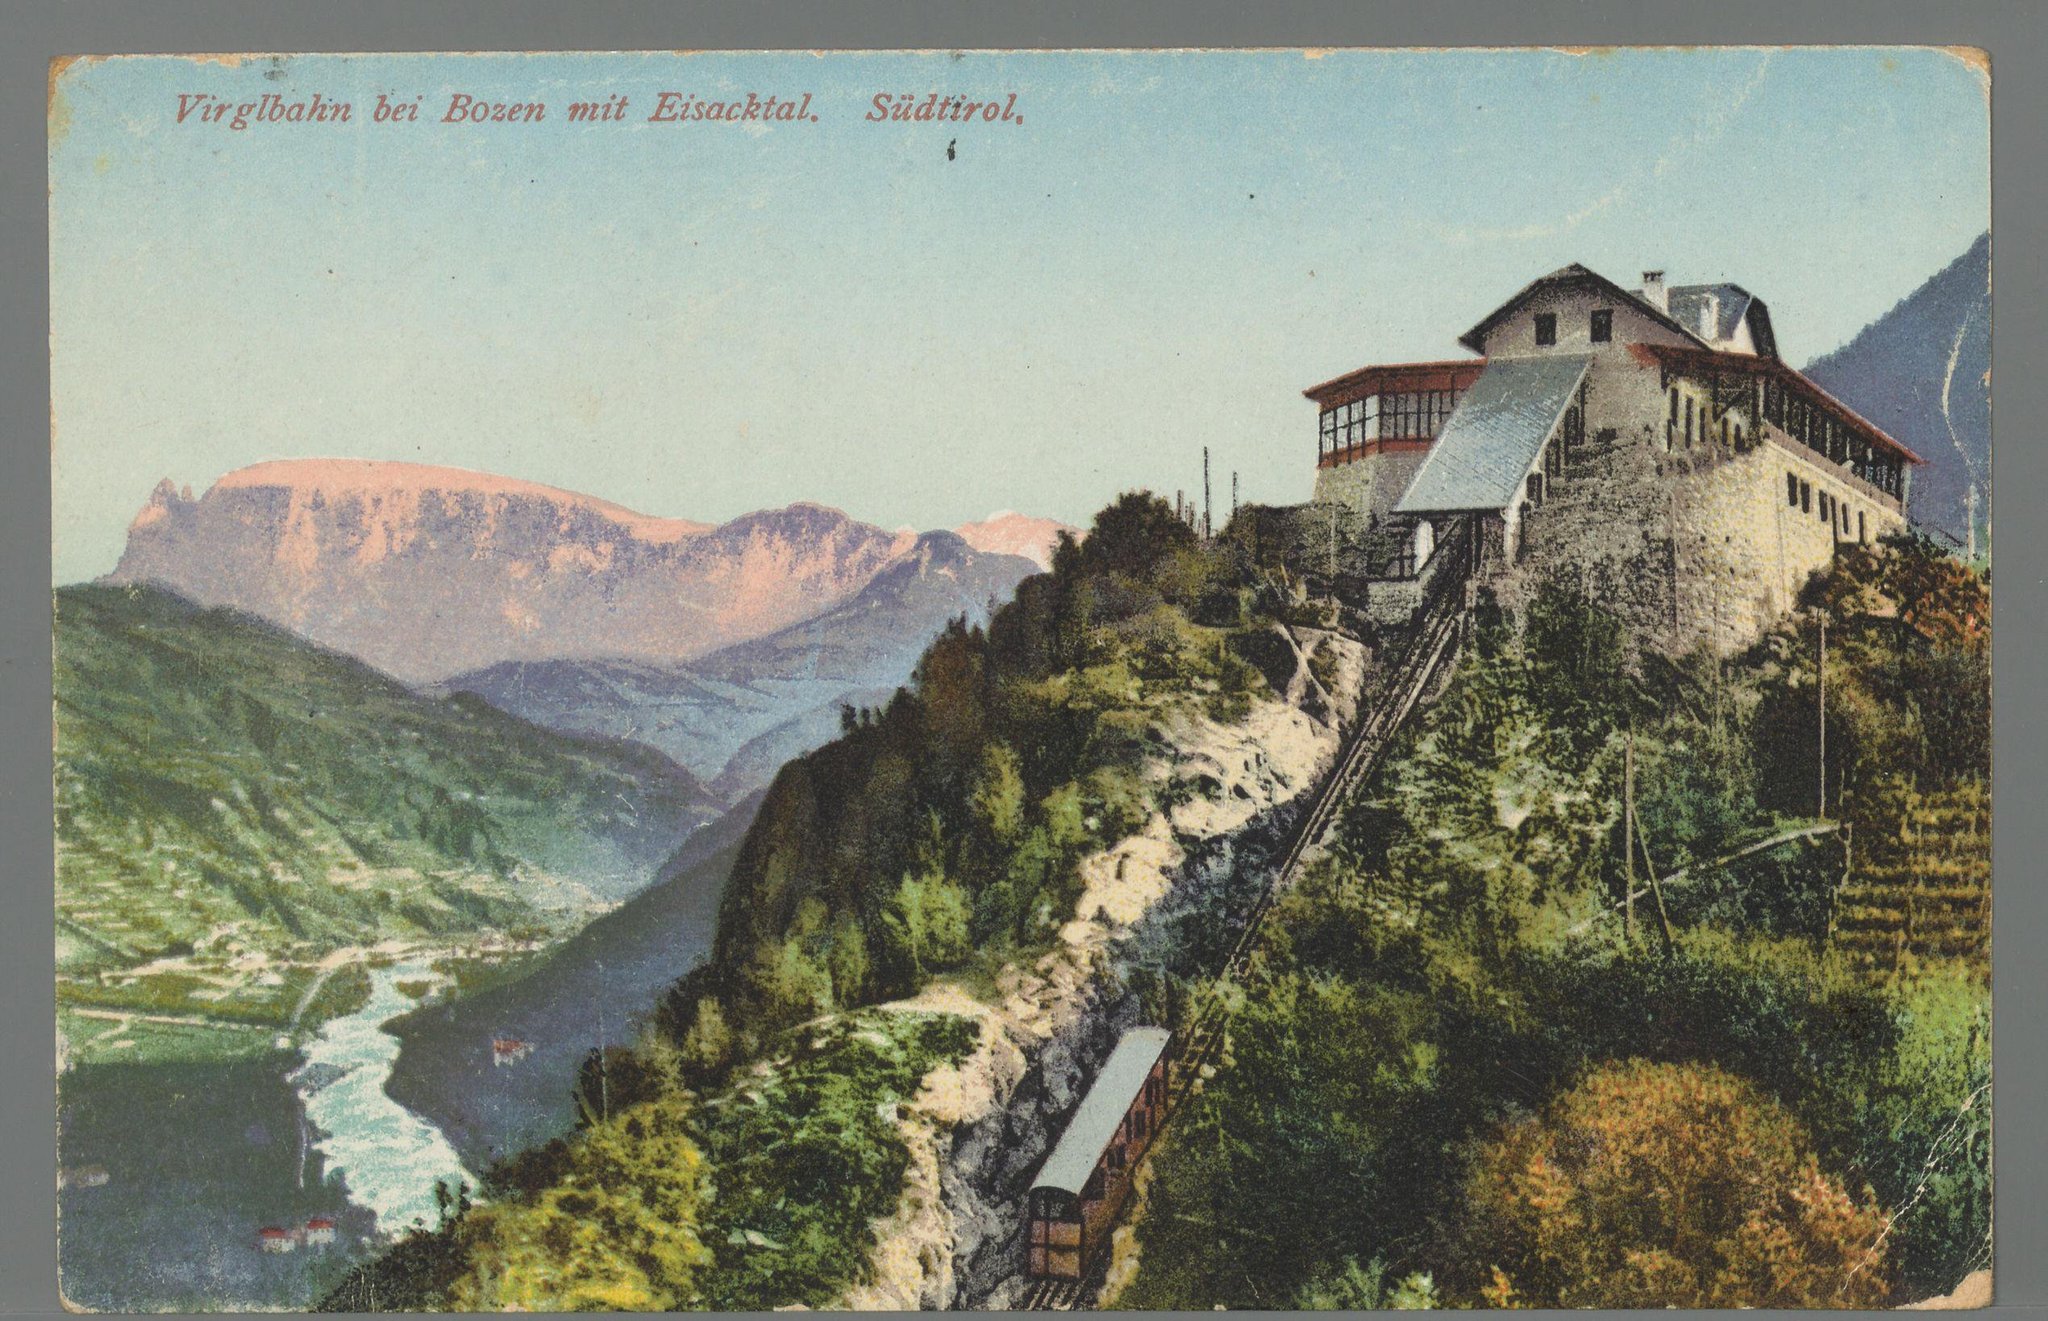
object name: photomechanical print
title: Virglbahn bei Bozen mit Eisacktal. Südtirol.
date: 1885-1915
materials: cardboard, photographic process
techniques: writing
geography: bolzano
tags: funicular railway, mountain-range, snow peaks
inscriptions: poststempel, verso, gestempeld